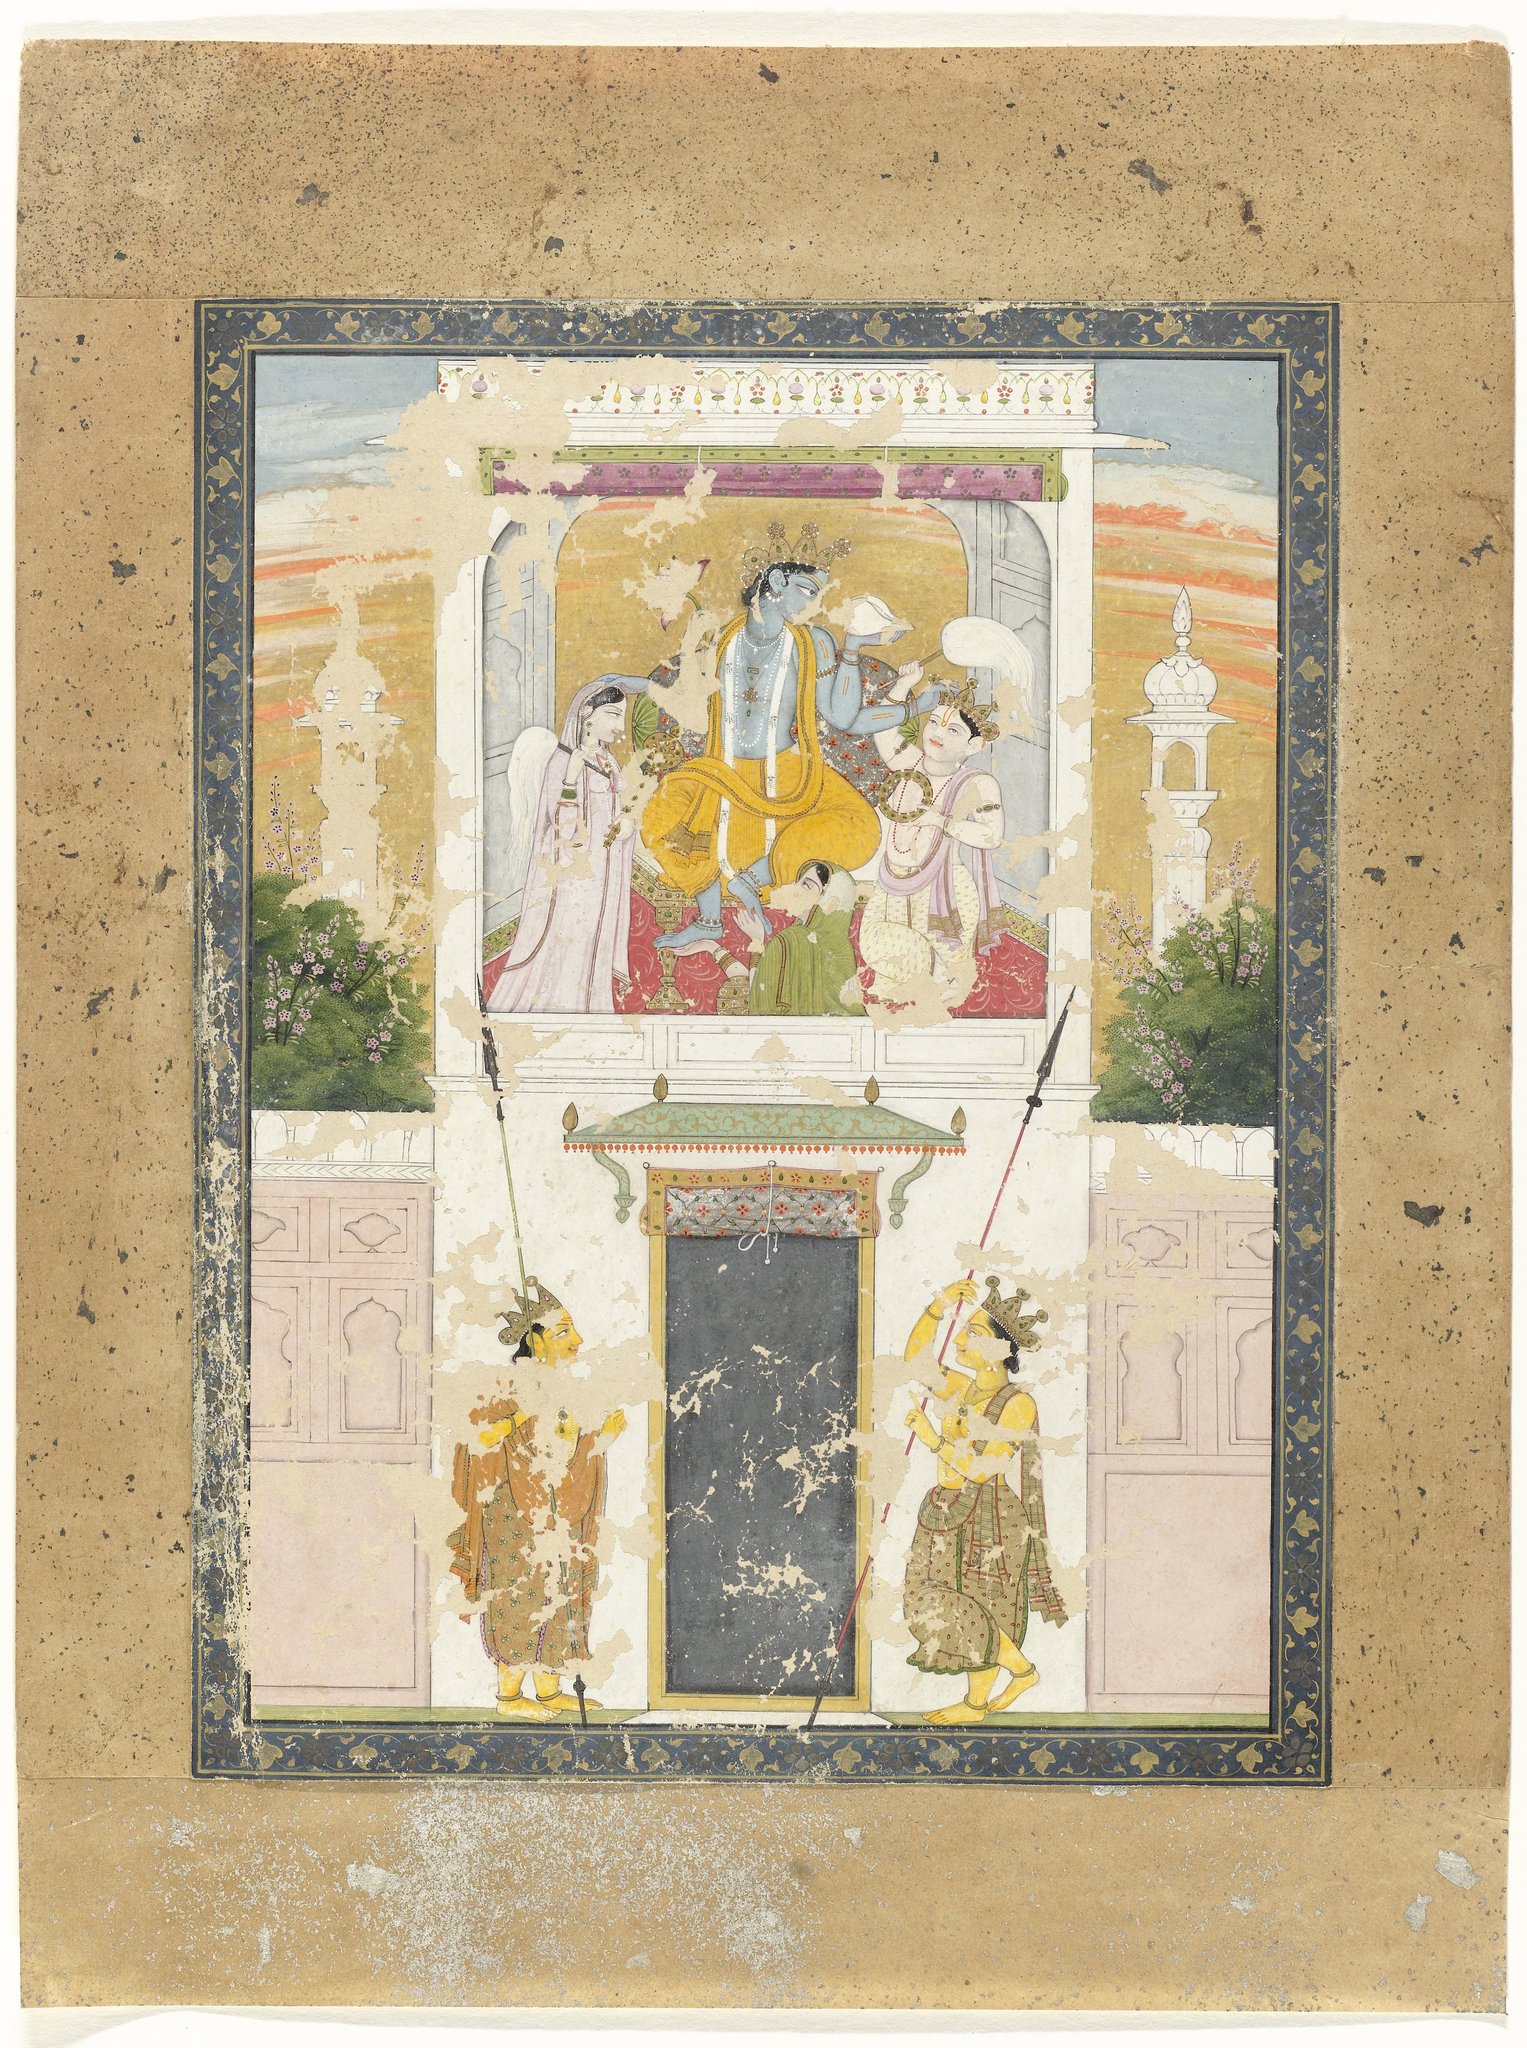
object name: indian miniature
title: Vishnu zittend op een troon op de eerste verdieping van een gebouw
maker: Anonymous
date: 1800-1825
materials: paint, gouache, paper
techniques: brush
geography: pahari